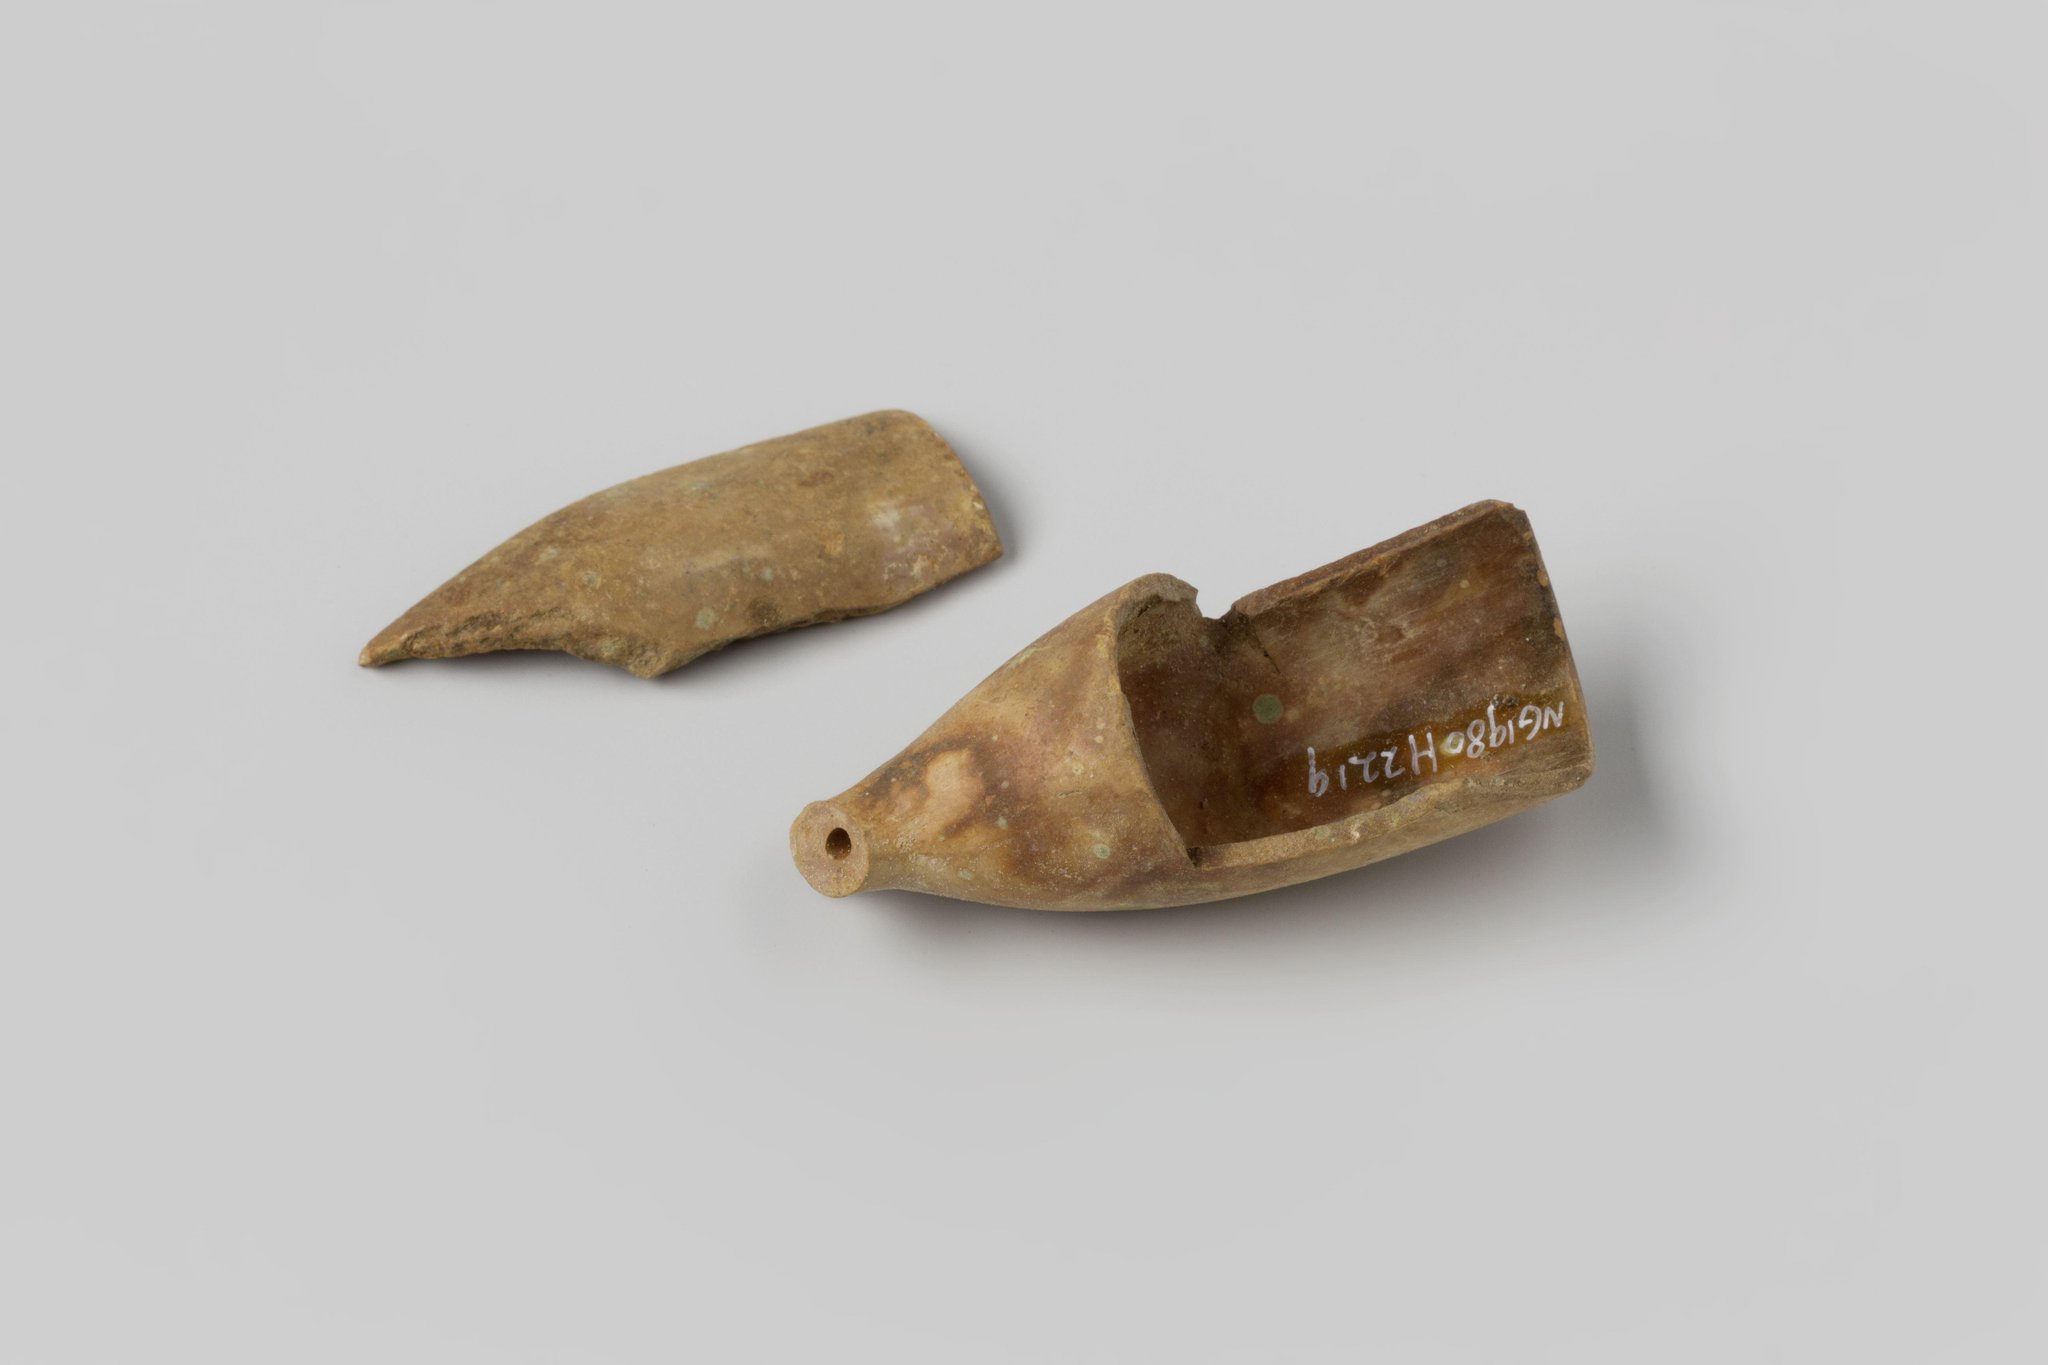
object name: pipe bowl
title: Fragmenten pijpenkoppen uit het wrak van de Oost-Indiëvaarder Hollandia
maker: Anonymous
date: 1700-1743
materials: clay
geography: netherlands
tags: verenigde oostindische compagnie, hollandia (schip), annet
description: Pipe, bowl, heelmark: crowned 82; fragment, no hsm.